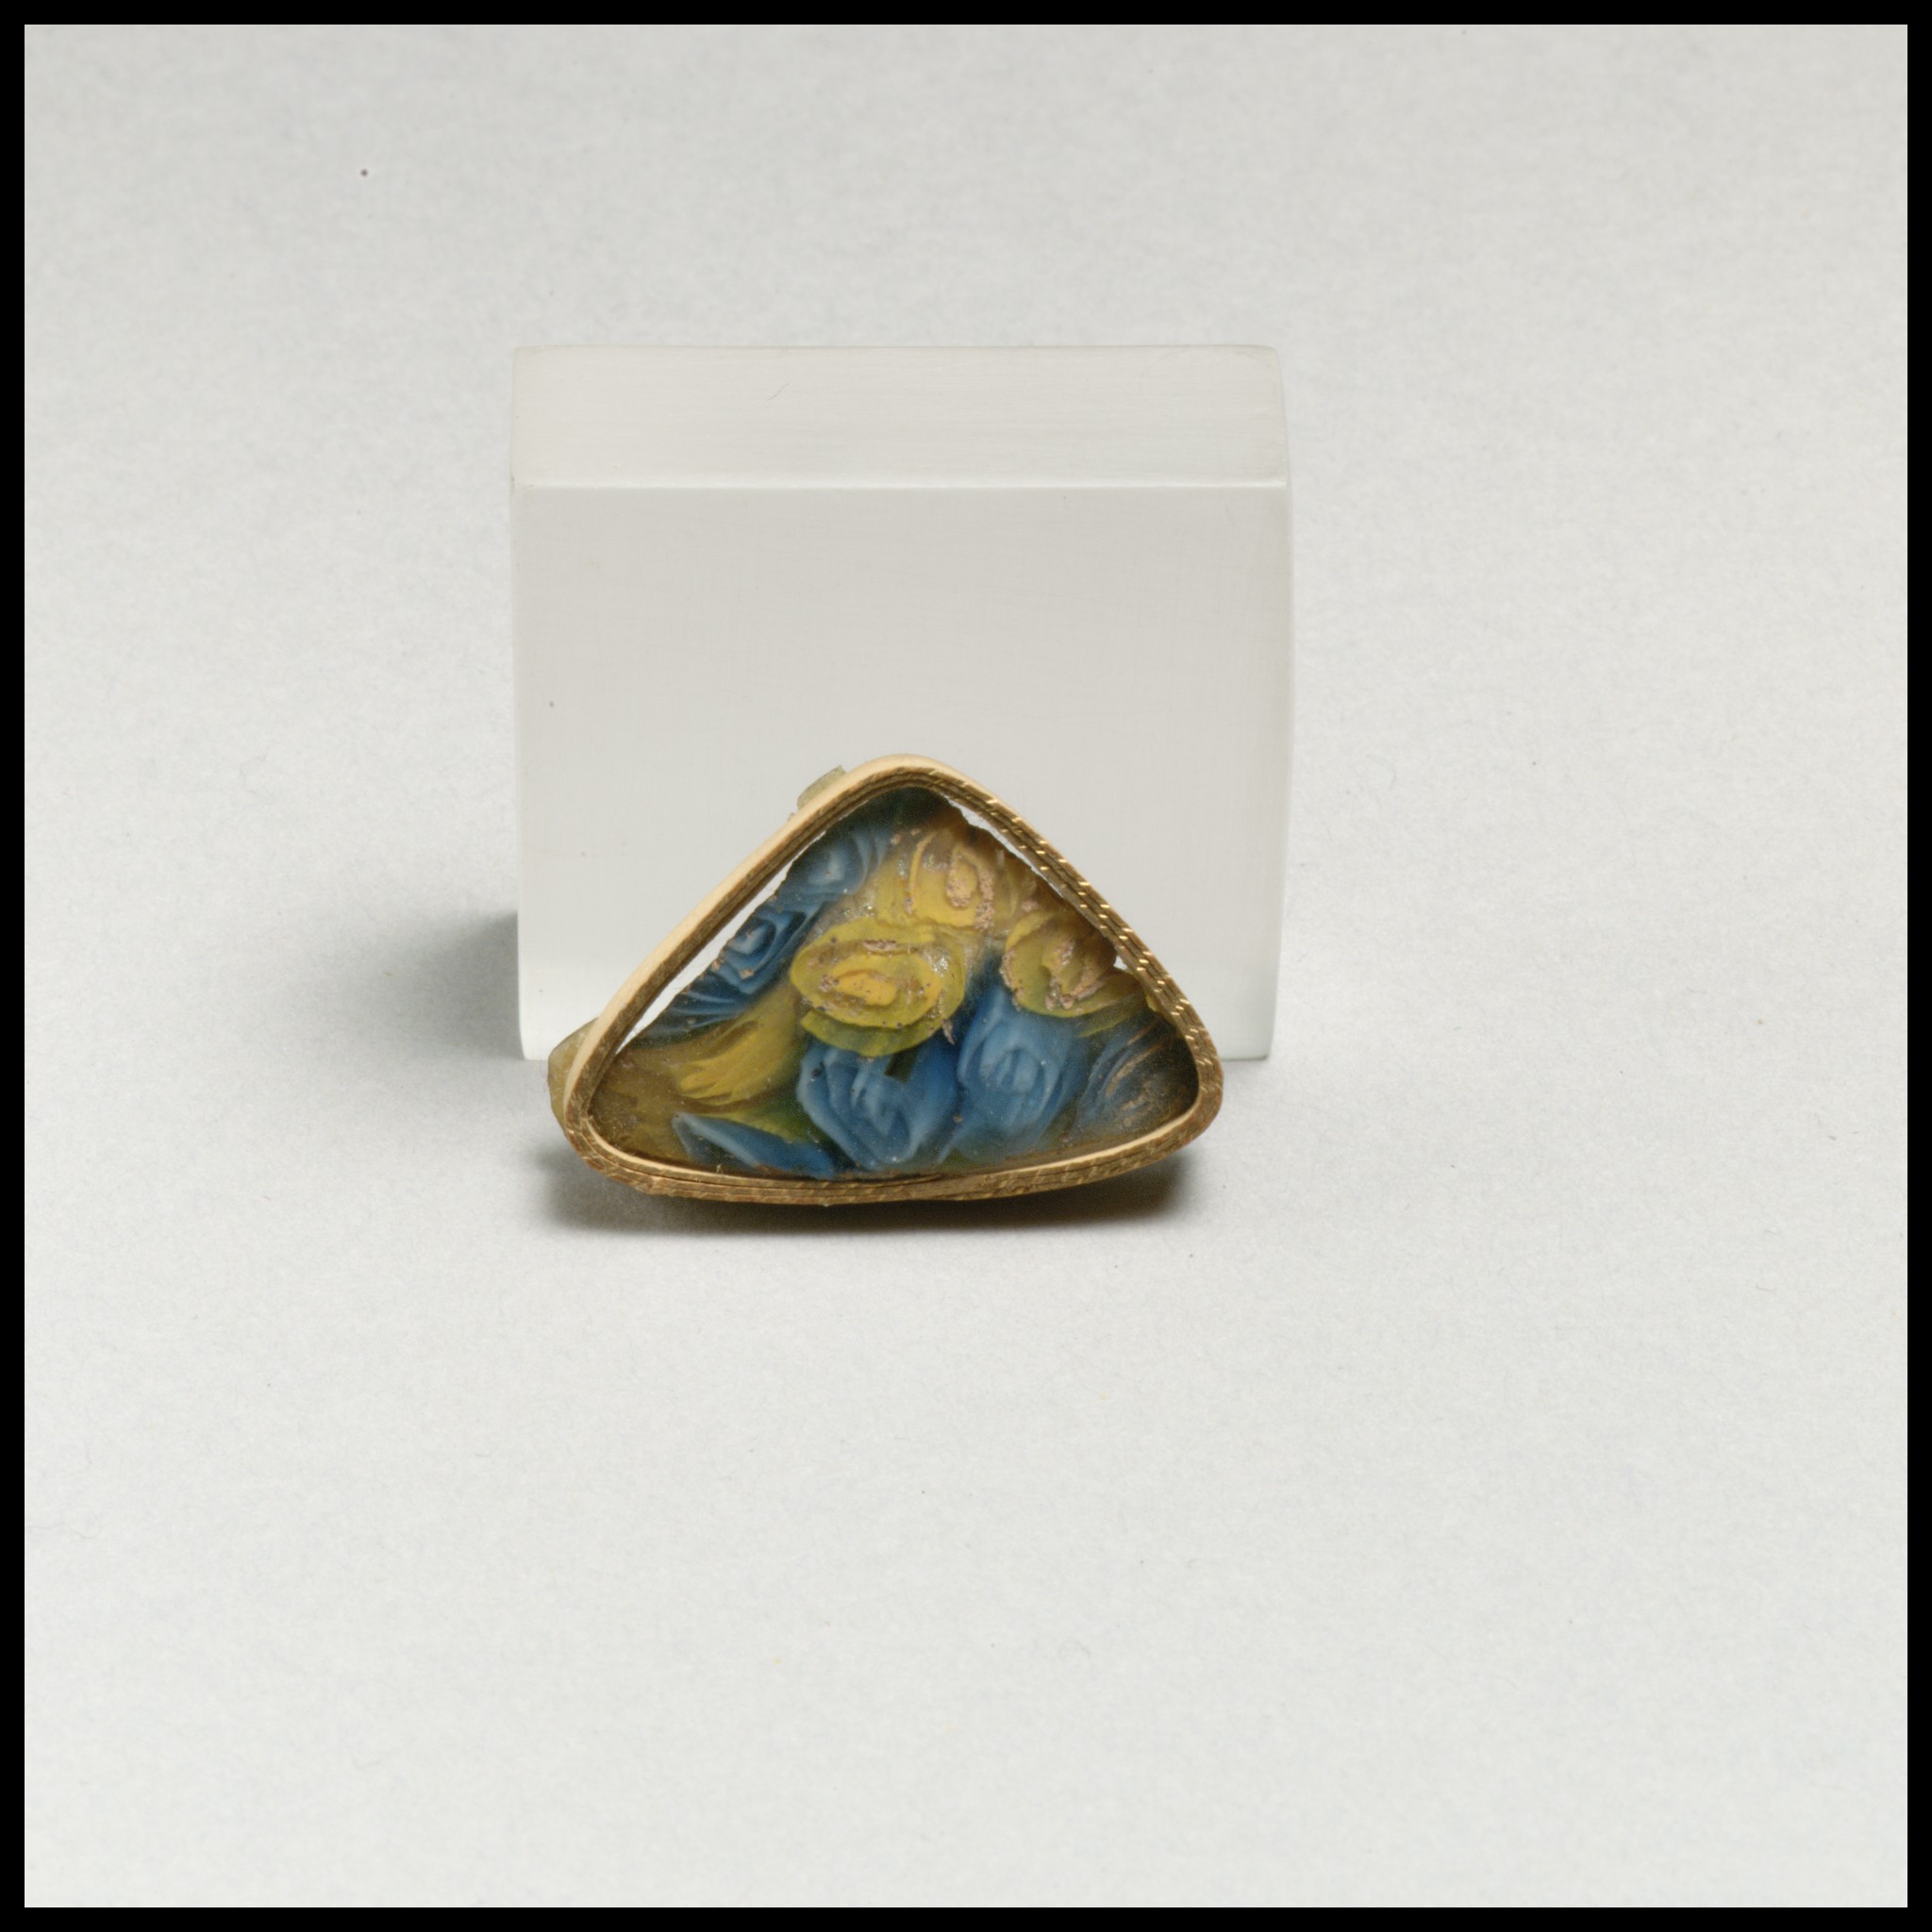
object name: fragment, mosaic bowl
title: Glass mosaic bowl fragment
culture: greek, eastern mediterranean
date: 200-35 BCE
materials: glass